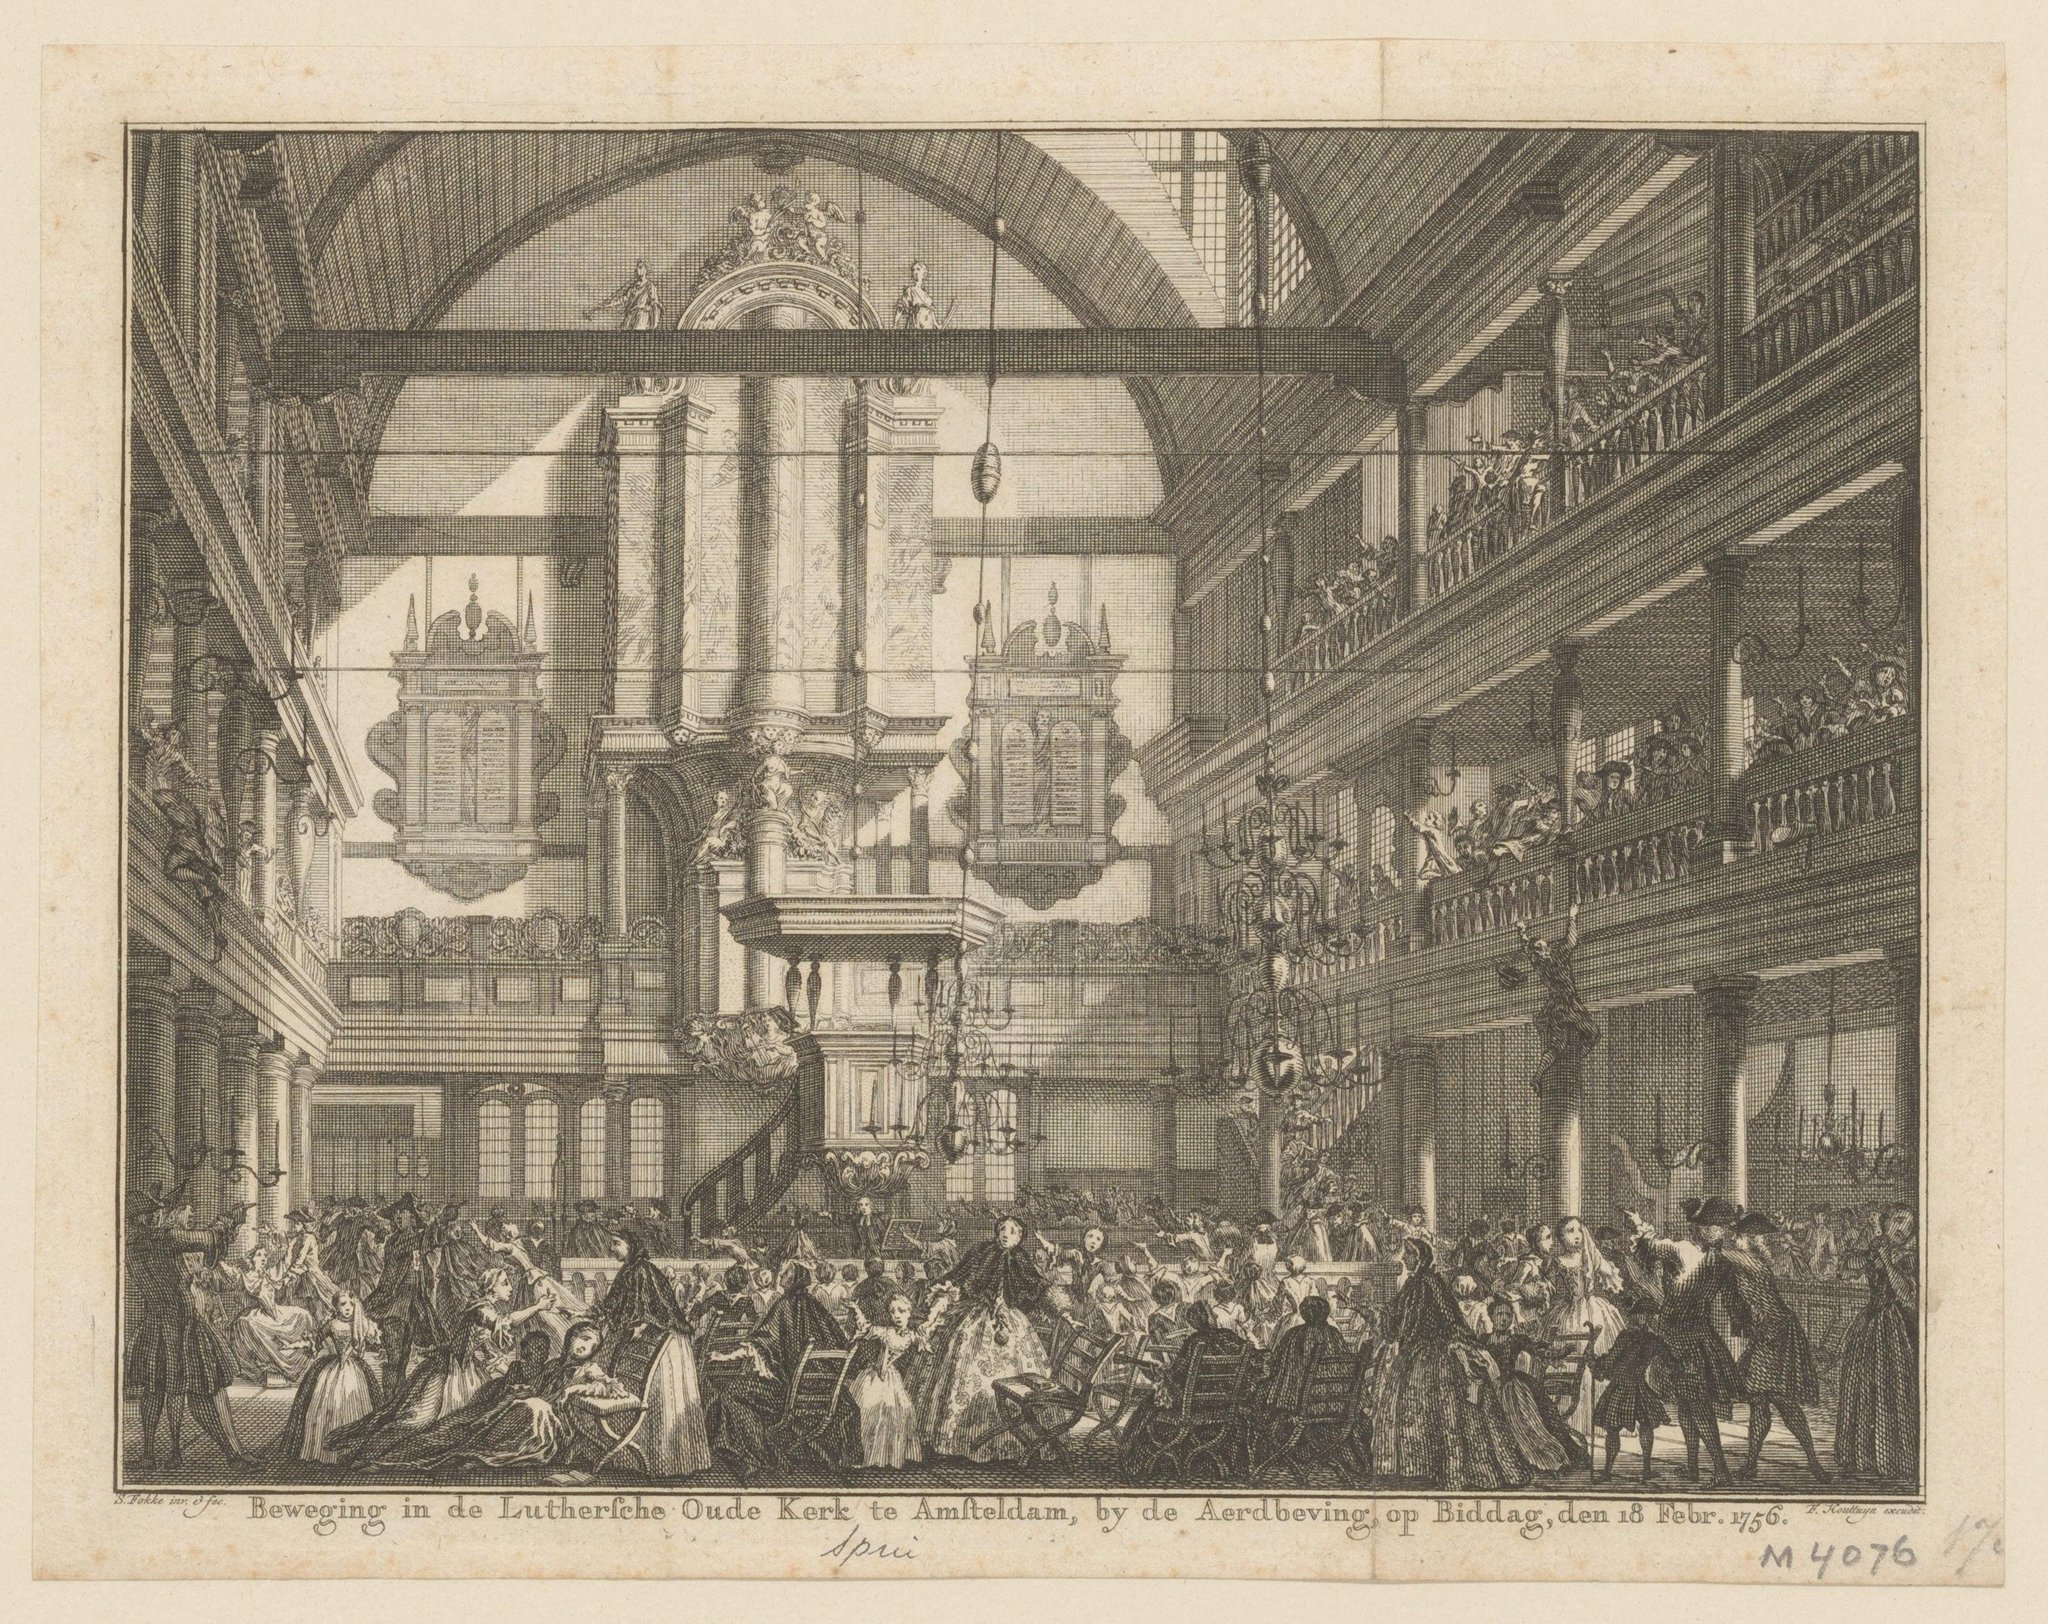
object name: print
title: Beweging in de Luthersche Oude Kerk te Amsteldam, by de Aerdbeving, op Biddag, den 18 Febr. 1756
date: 1756-1757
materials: paper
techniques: engraving, etching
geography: amsterdam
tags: protestant churches and denominations (lutherans), interior of church, earthquake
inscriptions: collector's mark: ‘35F-108’ Lugt 1641b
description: Prent ook gebruikt in: Nederlandsche Jaerboeken, inhoudende een verhael van de merkwaerdigste geschiedenissen (…), 10de dl, 1756. Amsterdam: Frans Houttuyn, s.a. [1756-1757], tussen p. 202 en 203.